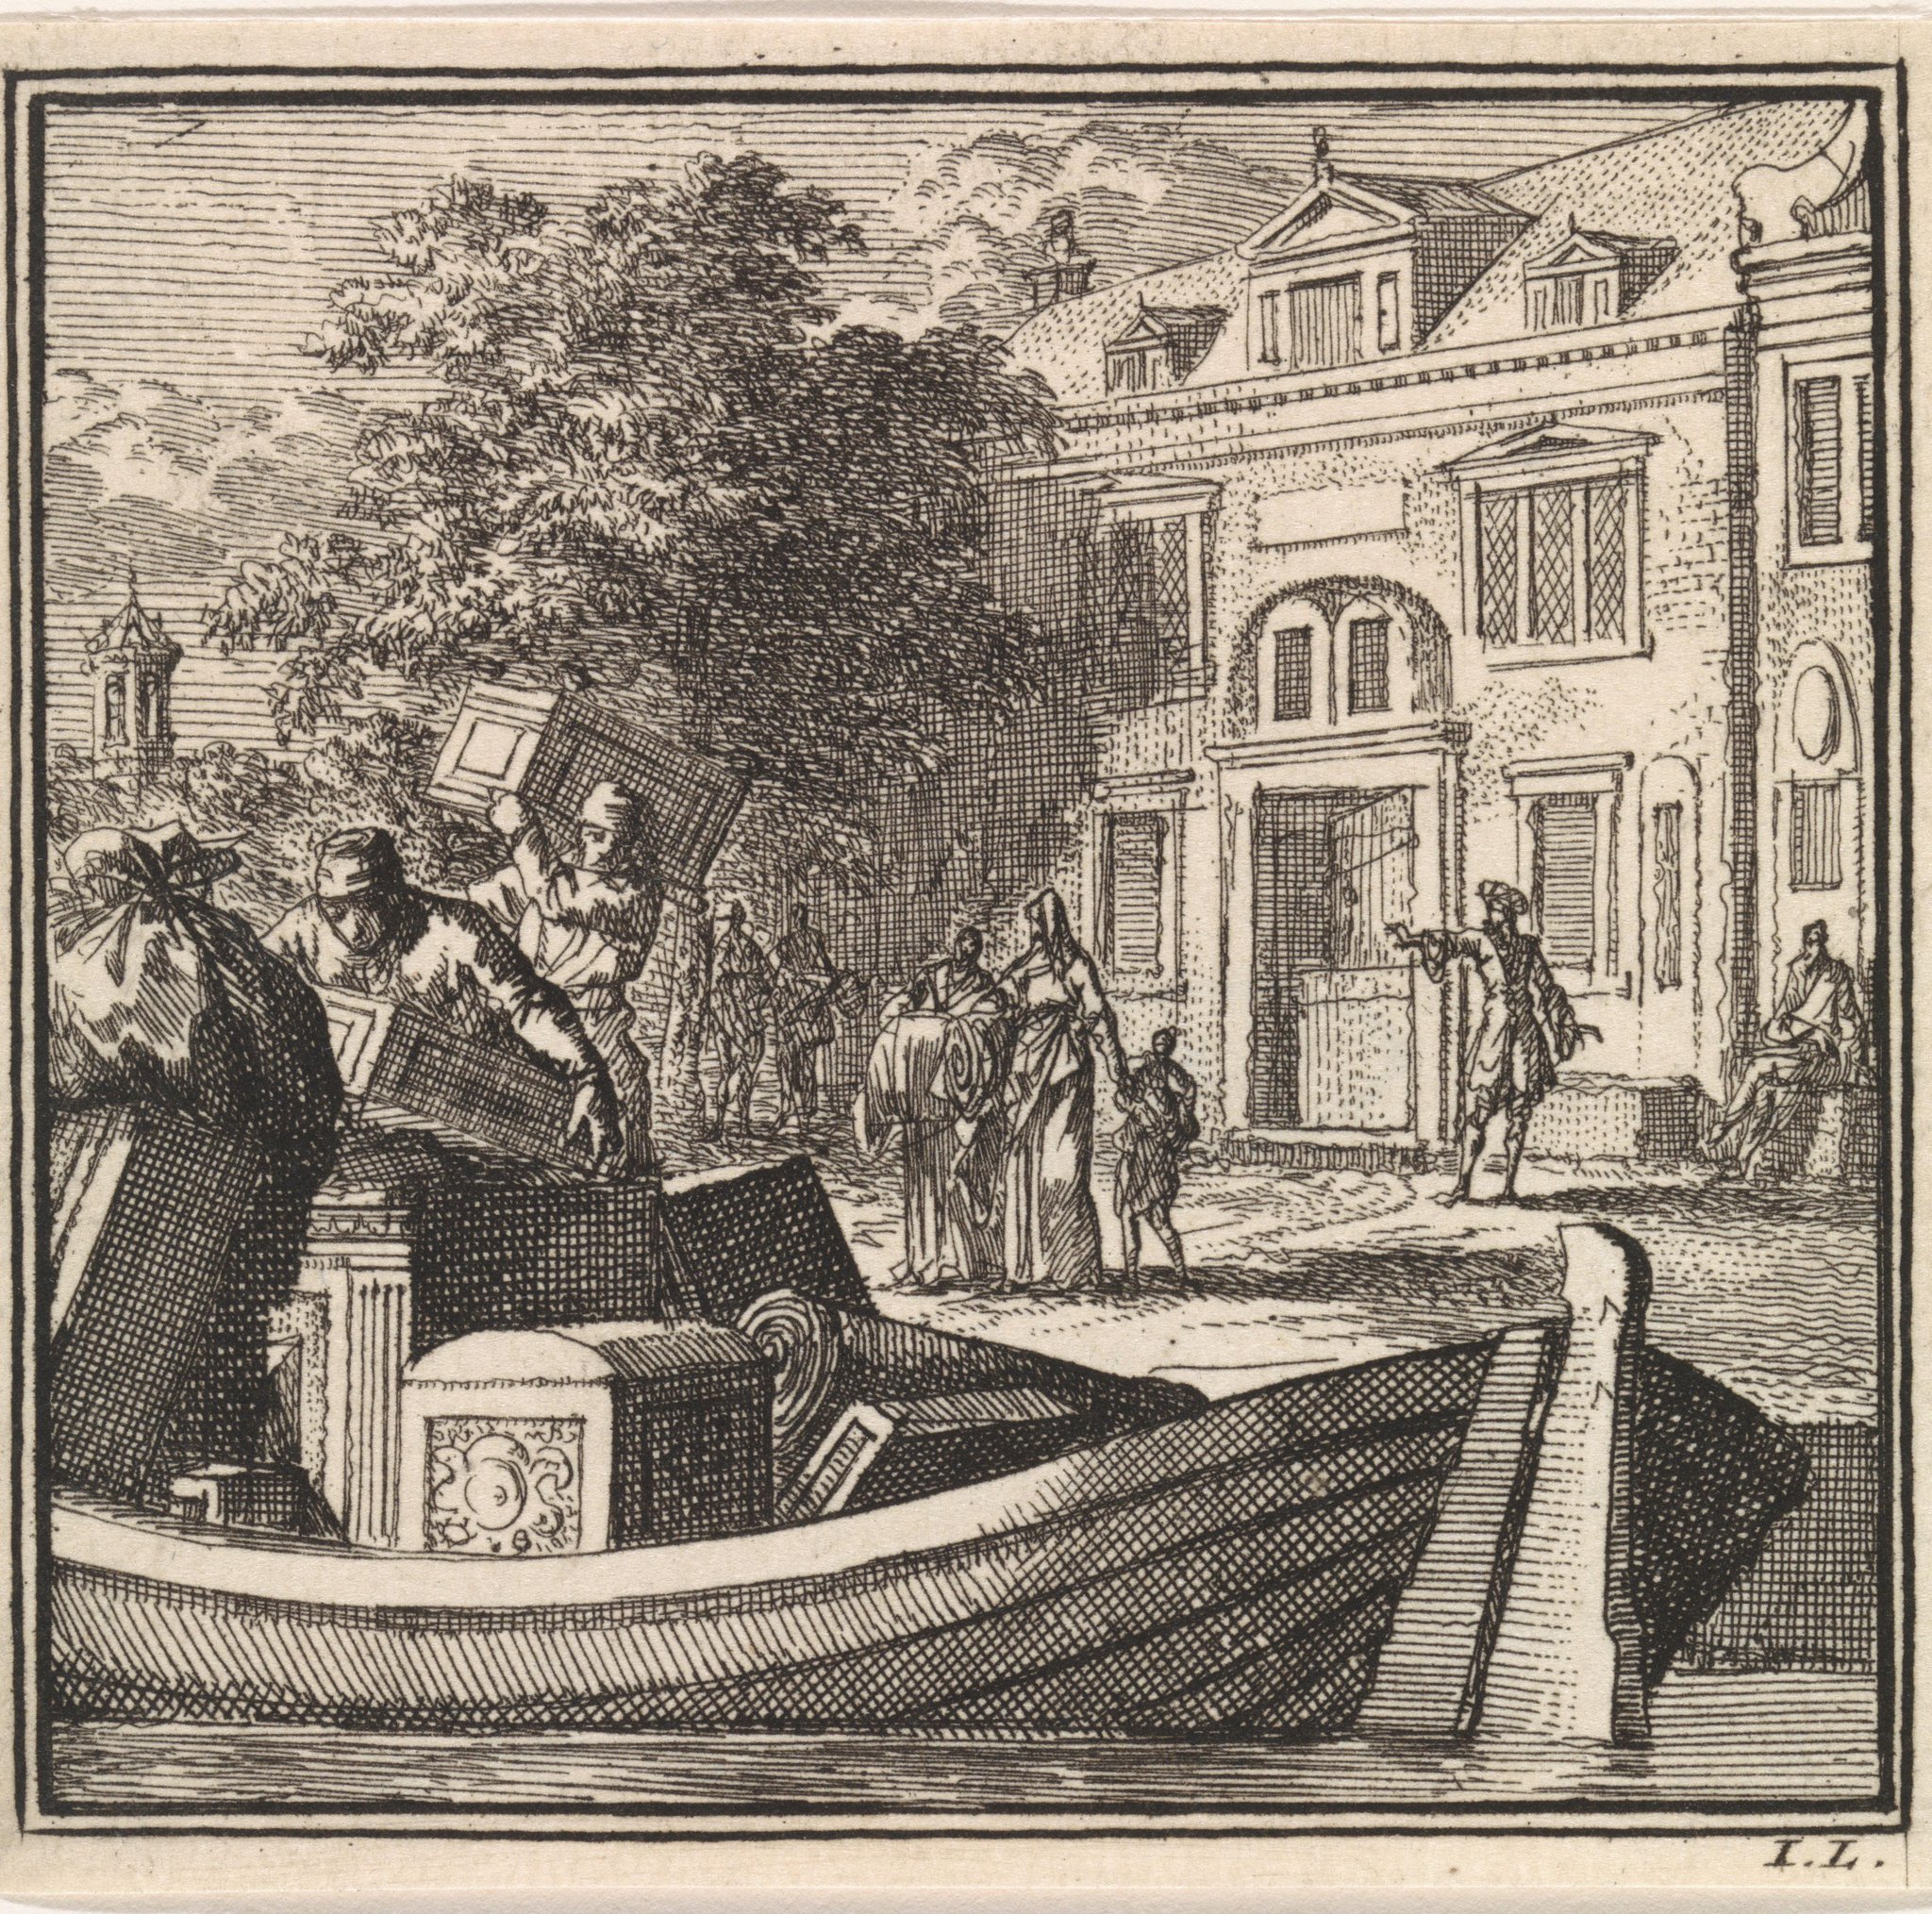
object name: book illustration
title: De Verhuizing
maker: jan luyken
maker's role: draughtsman, print maker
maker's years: 1649-1712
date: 1711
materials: paper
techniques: etching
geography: amsterdam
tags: moving (house), rowing-boat, canoe, etc.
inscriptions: collector's mark: Lugt 2228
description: Illustratie voor: Luyken, Jan. De Bykorf des Gemoeds. Amsterdam: Pieter Arentsz. II (wed.) en Cornelis van der Sys, 1711, p. 322.